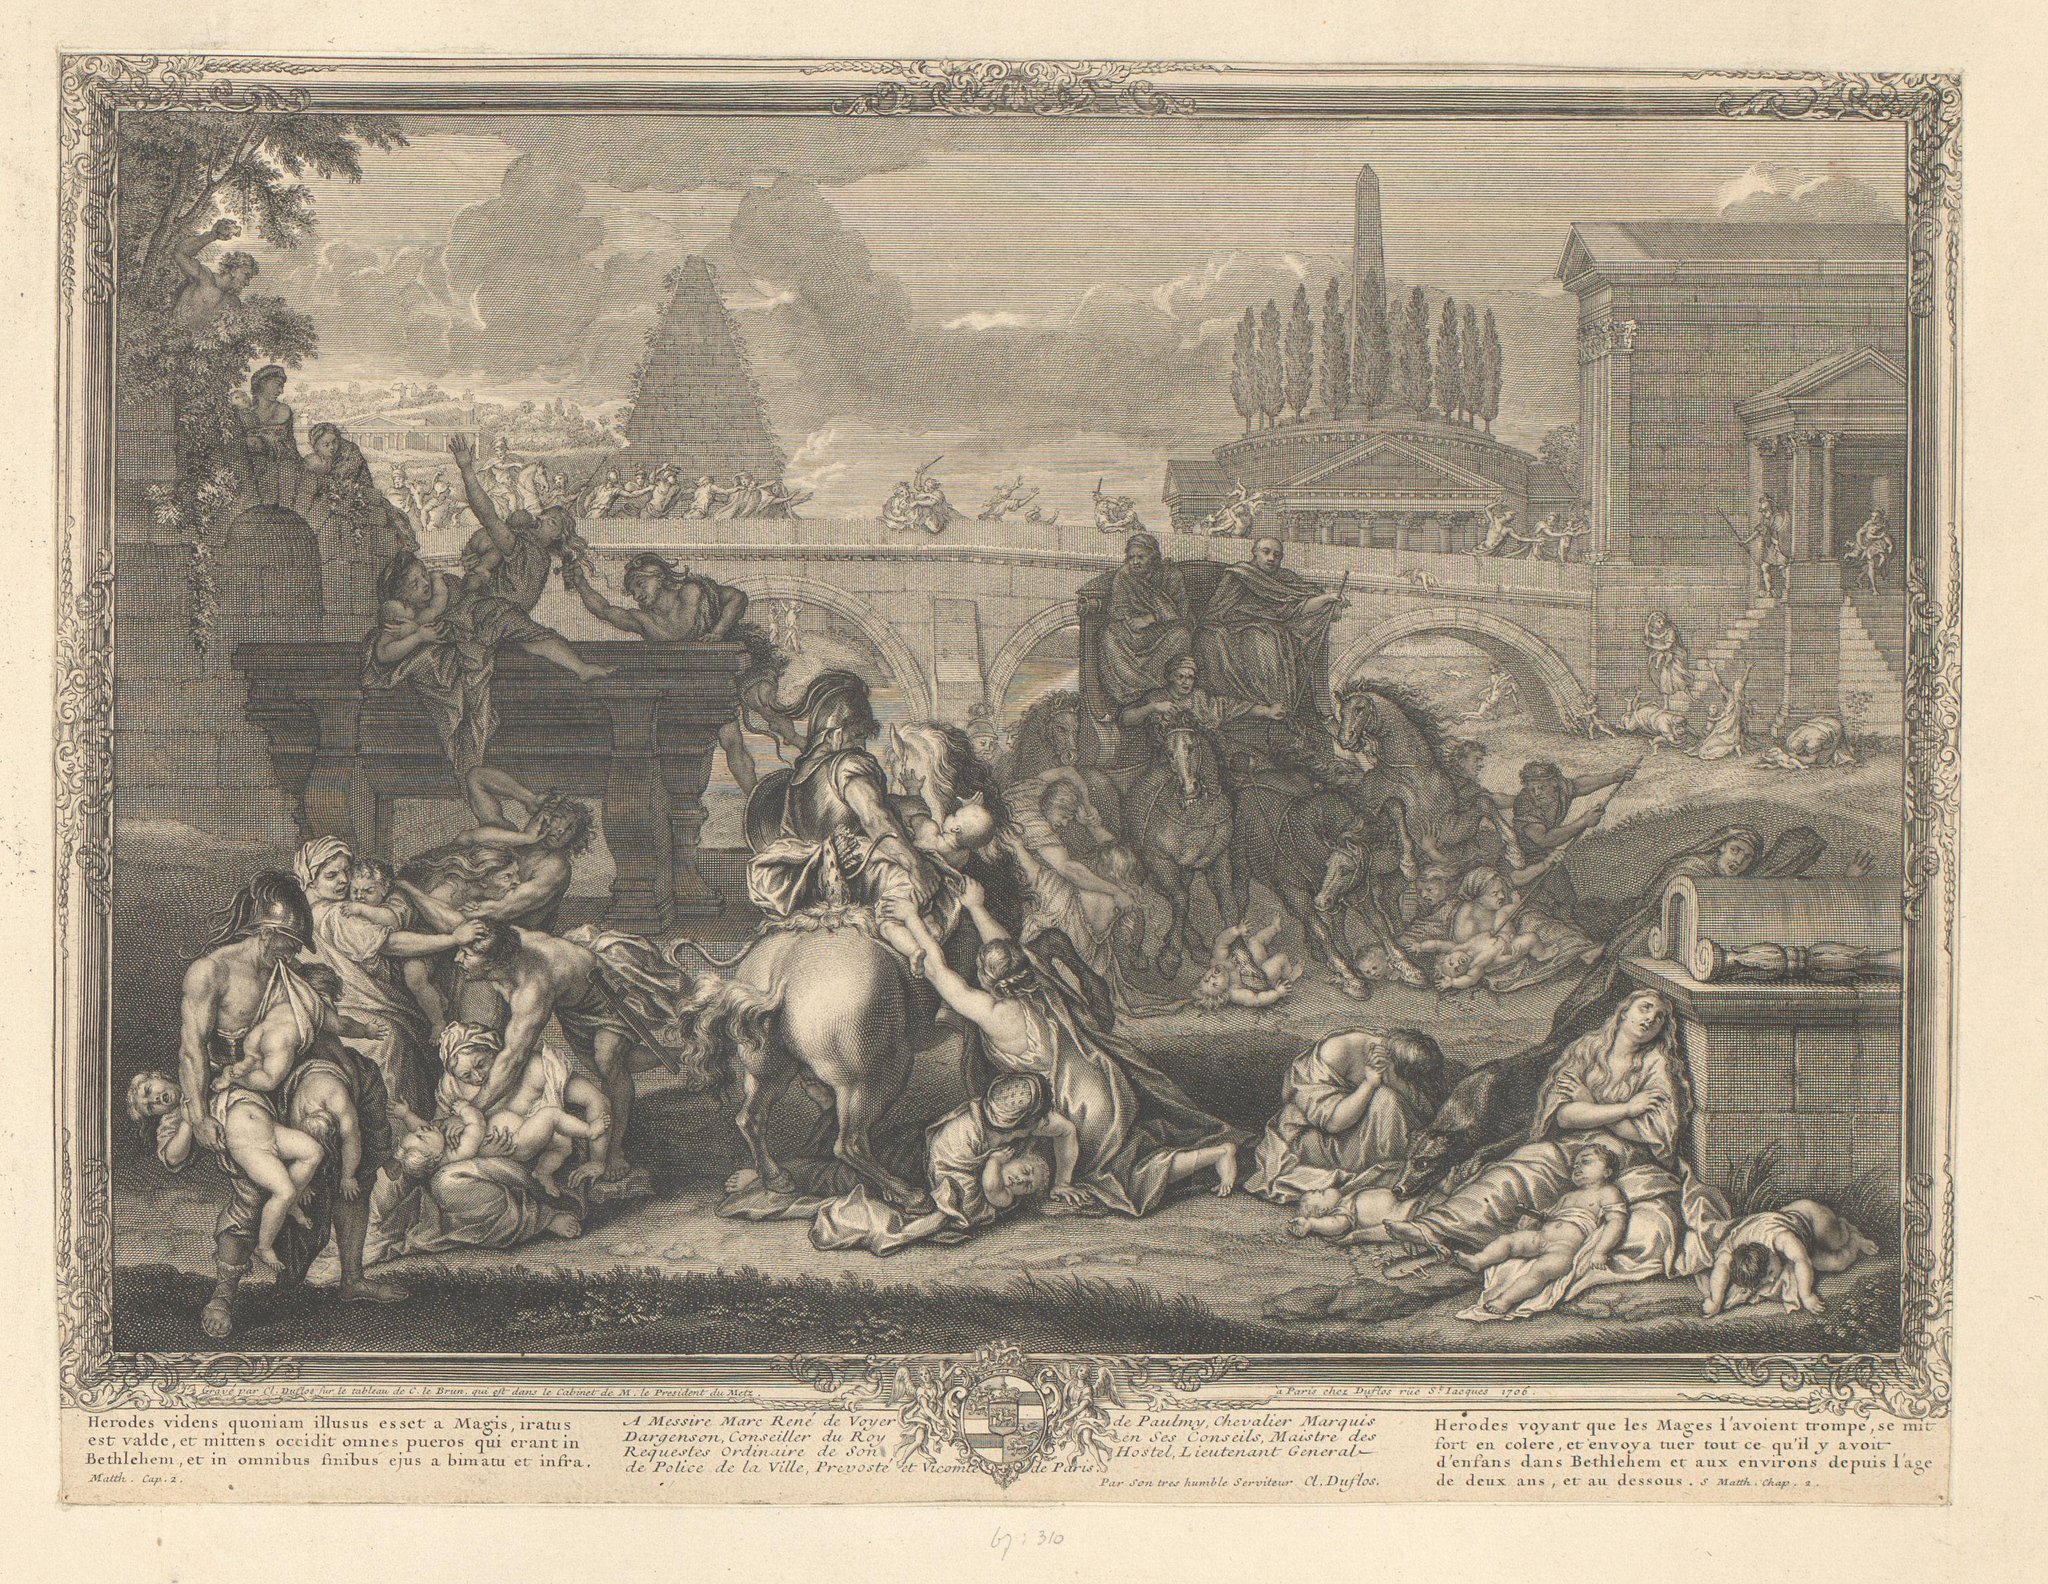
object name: album leaf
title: L'ouvrage de Charles le Brun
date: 1706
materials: paper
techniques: engraving, etching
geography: paris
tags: the massacre of the innocents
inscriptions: date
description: Deze prent maakt deel uit van een album.